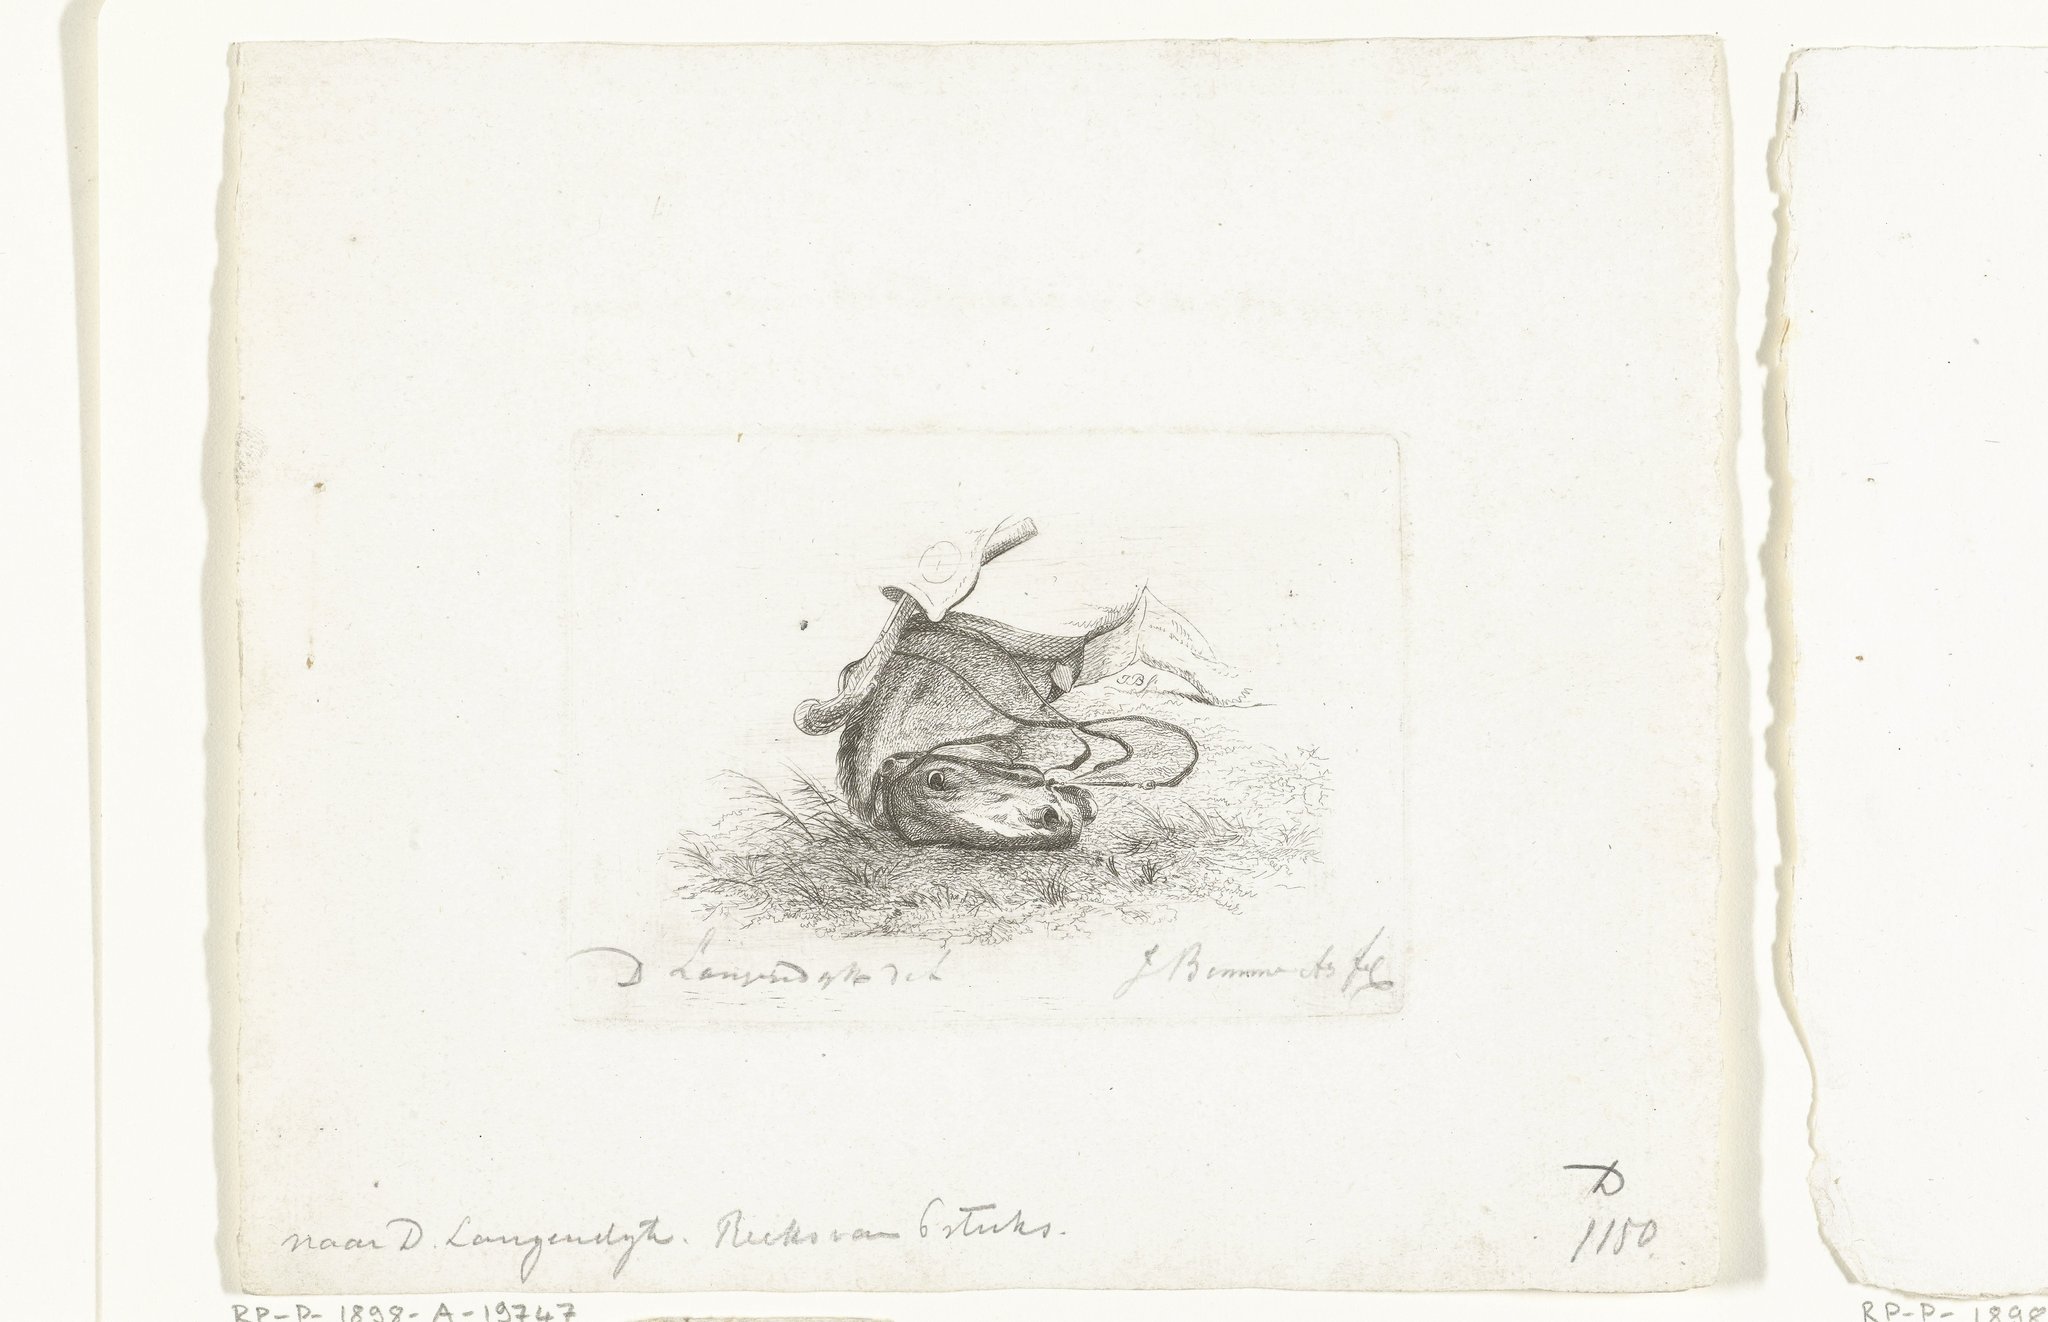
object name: print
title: Paardenhoofden naar Dirk Langendijk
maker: joannes bemme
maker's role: print maker, printer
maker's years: 1775-1841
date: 1800-1841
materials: paper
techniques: etching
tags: horse (+ head of an animal)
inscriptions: collector's mark: Lugt 2228